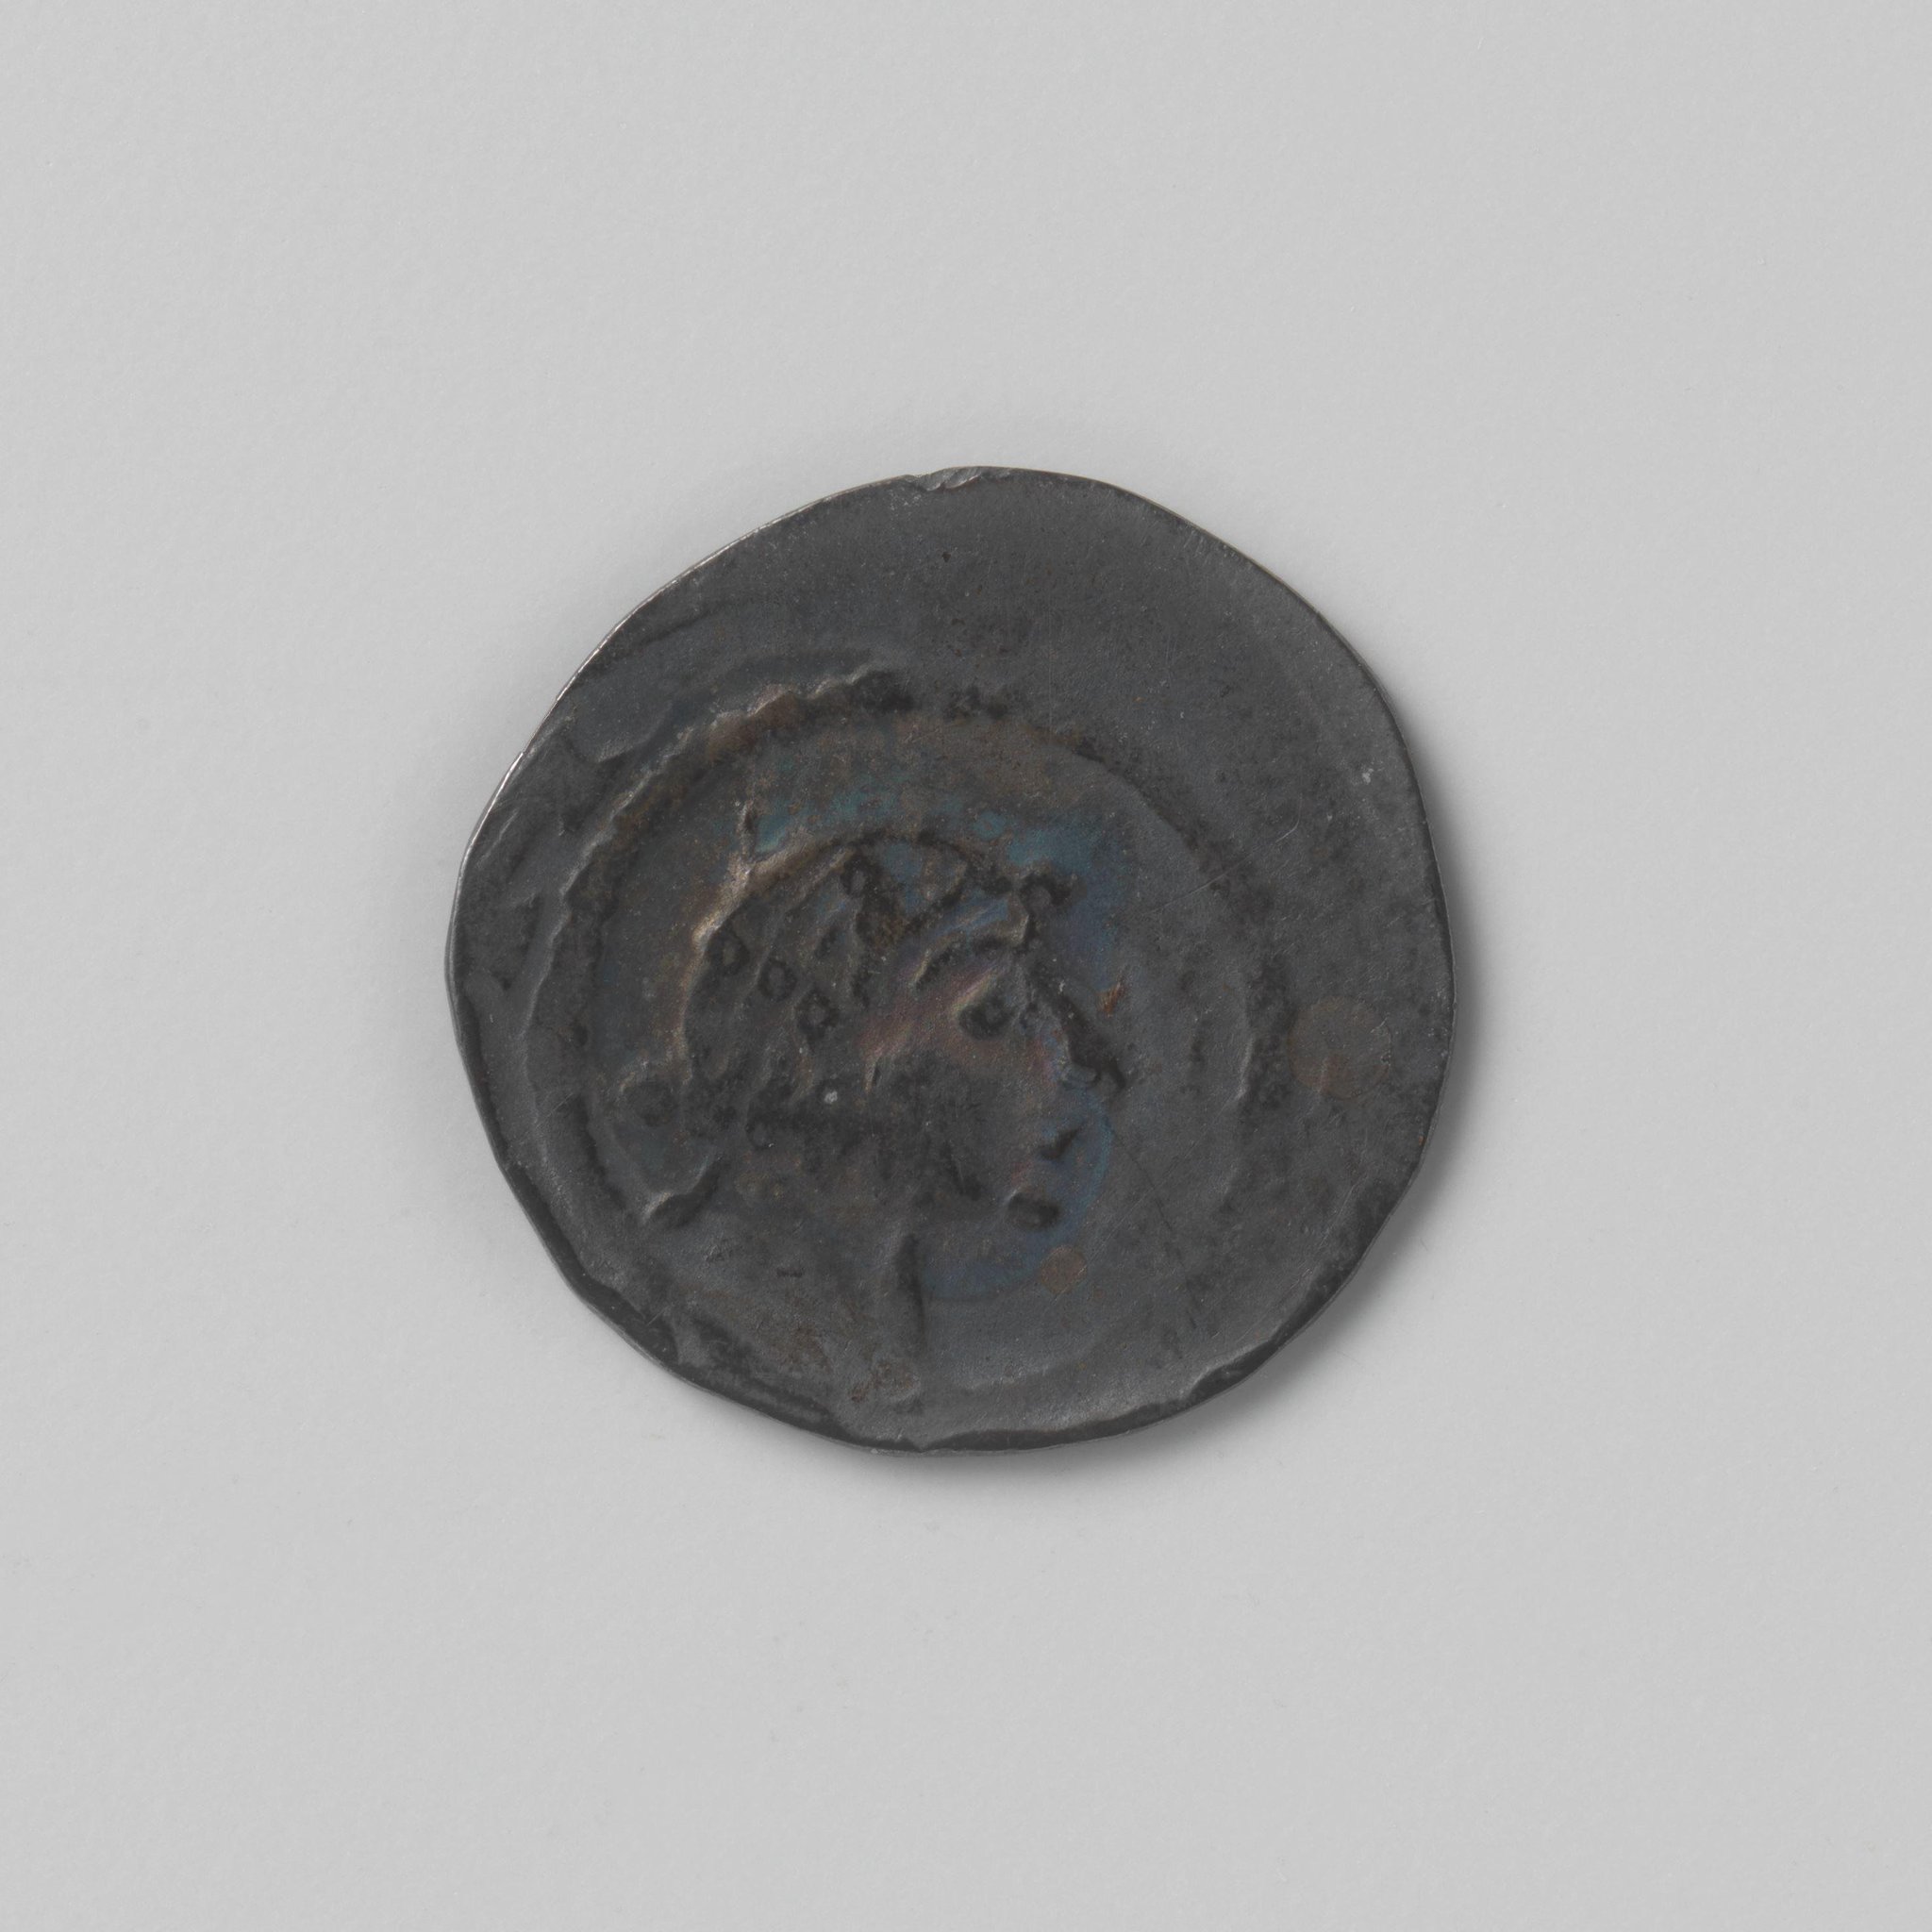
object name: coin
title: Hollandse penning van Floris V, 1256-1296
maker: floris v (graaf van holland en zeeland)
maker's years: 1254-1296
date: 1256-1258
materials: silver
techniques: striking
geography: dordrecht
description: Zilveren munt. Voorzijde: hoofd met gravenmuts naar rechts. Keerzijde: lang dubbellijnig kruis.